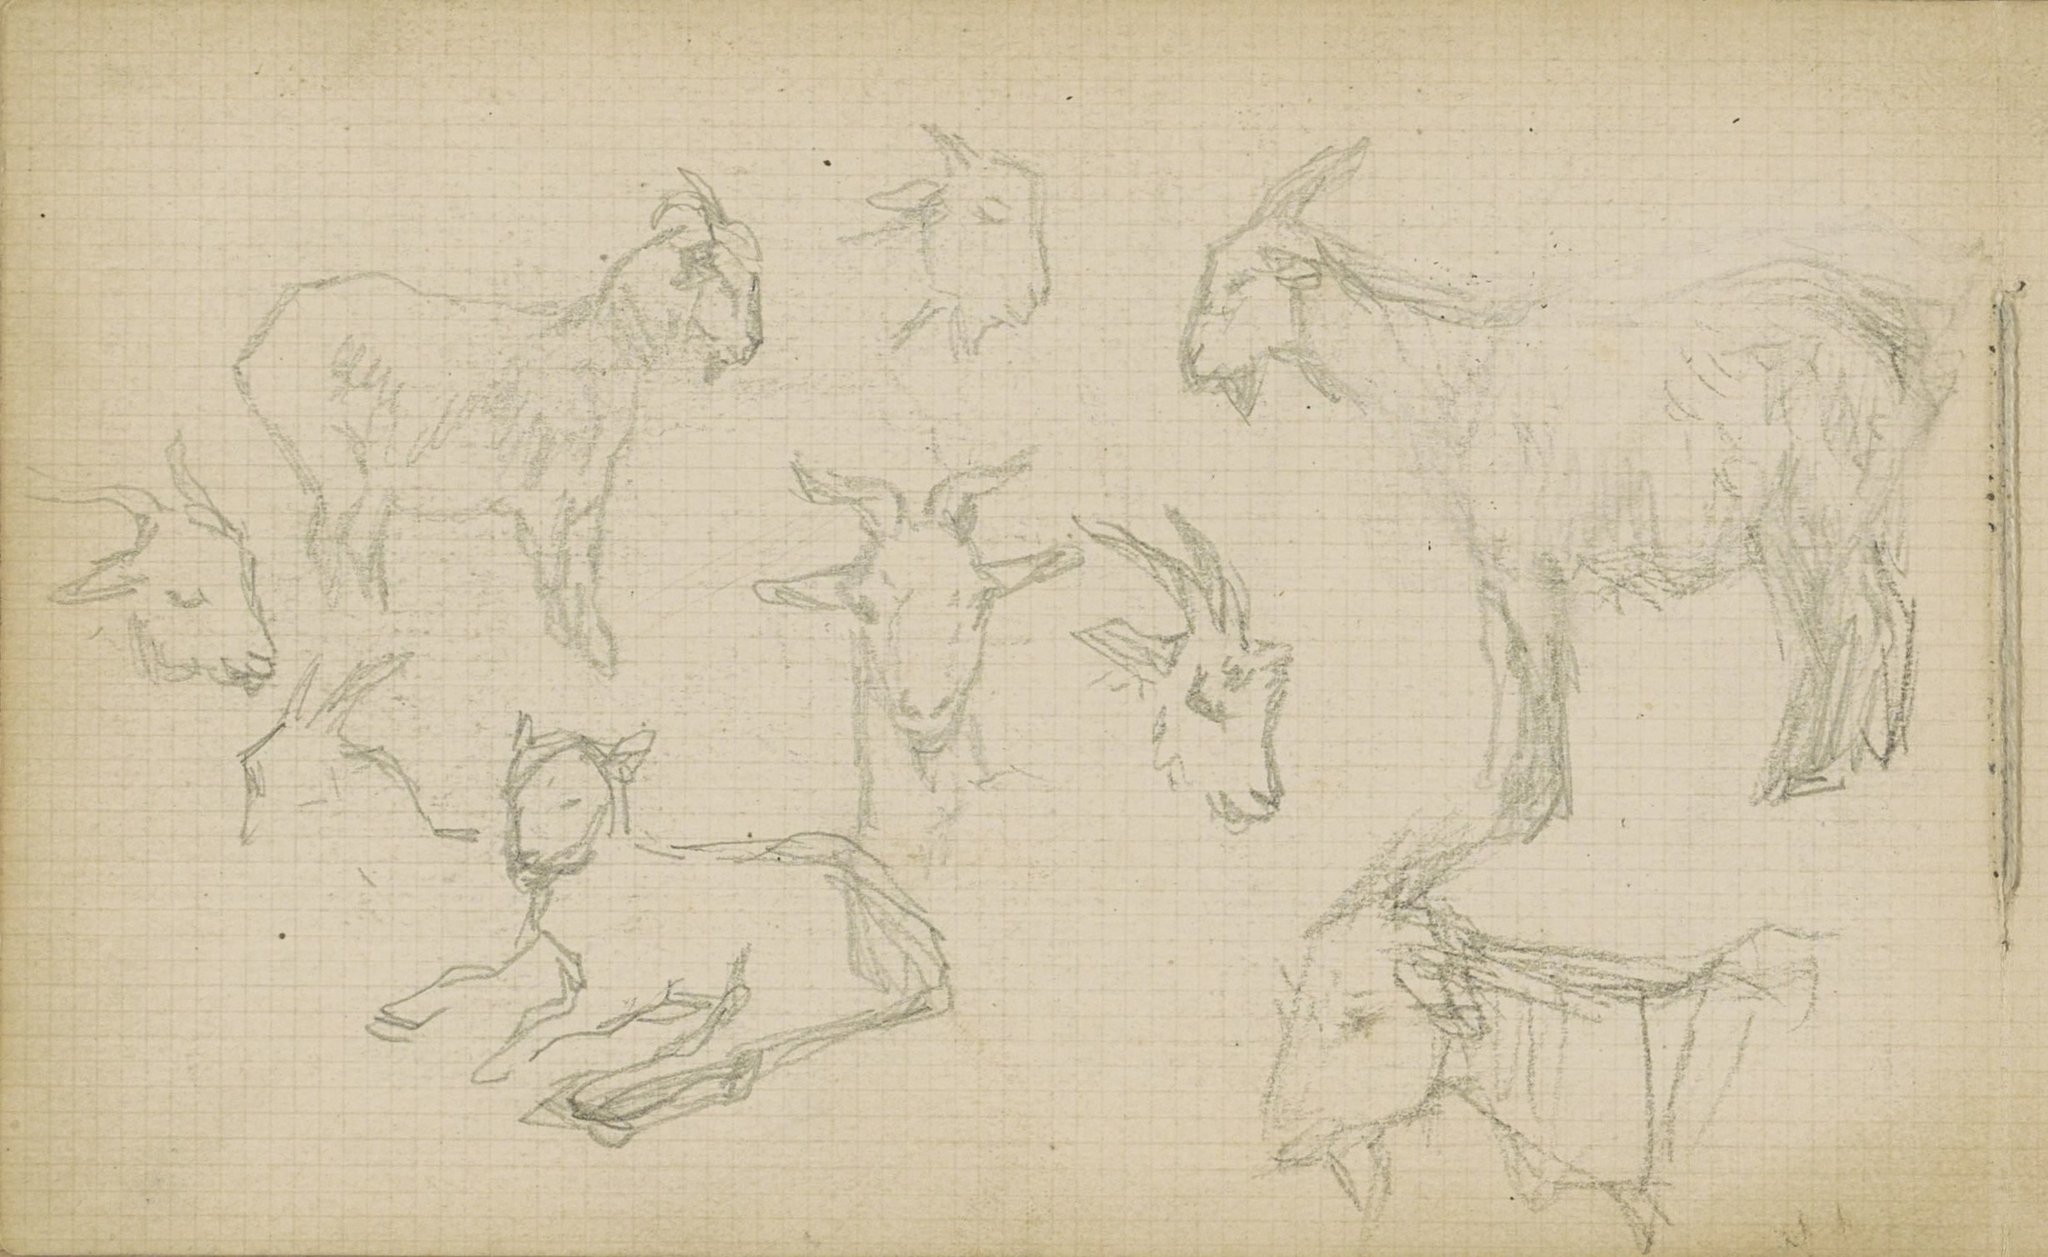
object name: sketchbook leaf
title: Geiten en geitenkoppen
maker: matthijs maris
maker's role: draughtsman, painter, print maker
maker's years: 1839-1917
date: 1849-1917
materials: pencil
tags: goat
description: Blad 29 verso uit een schetsboek met 35 bladen.